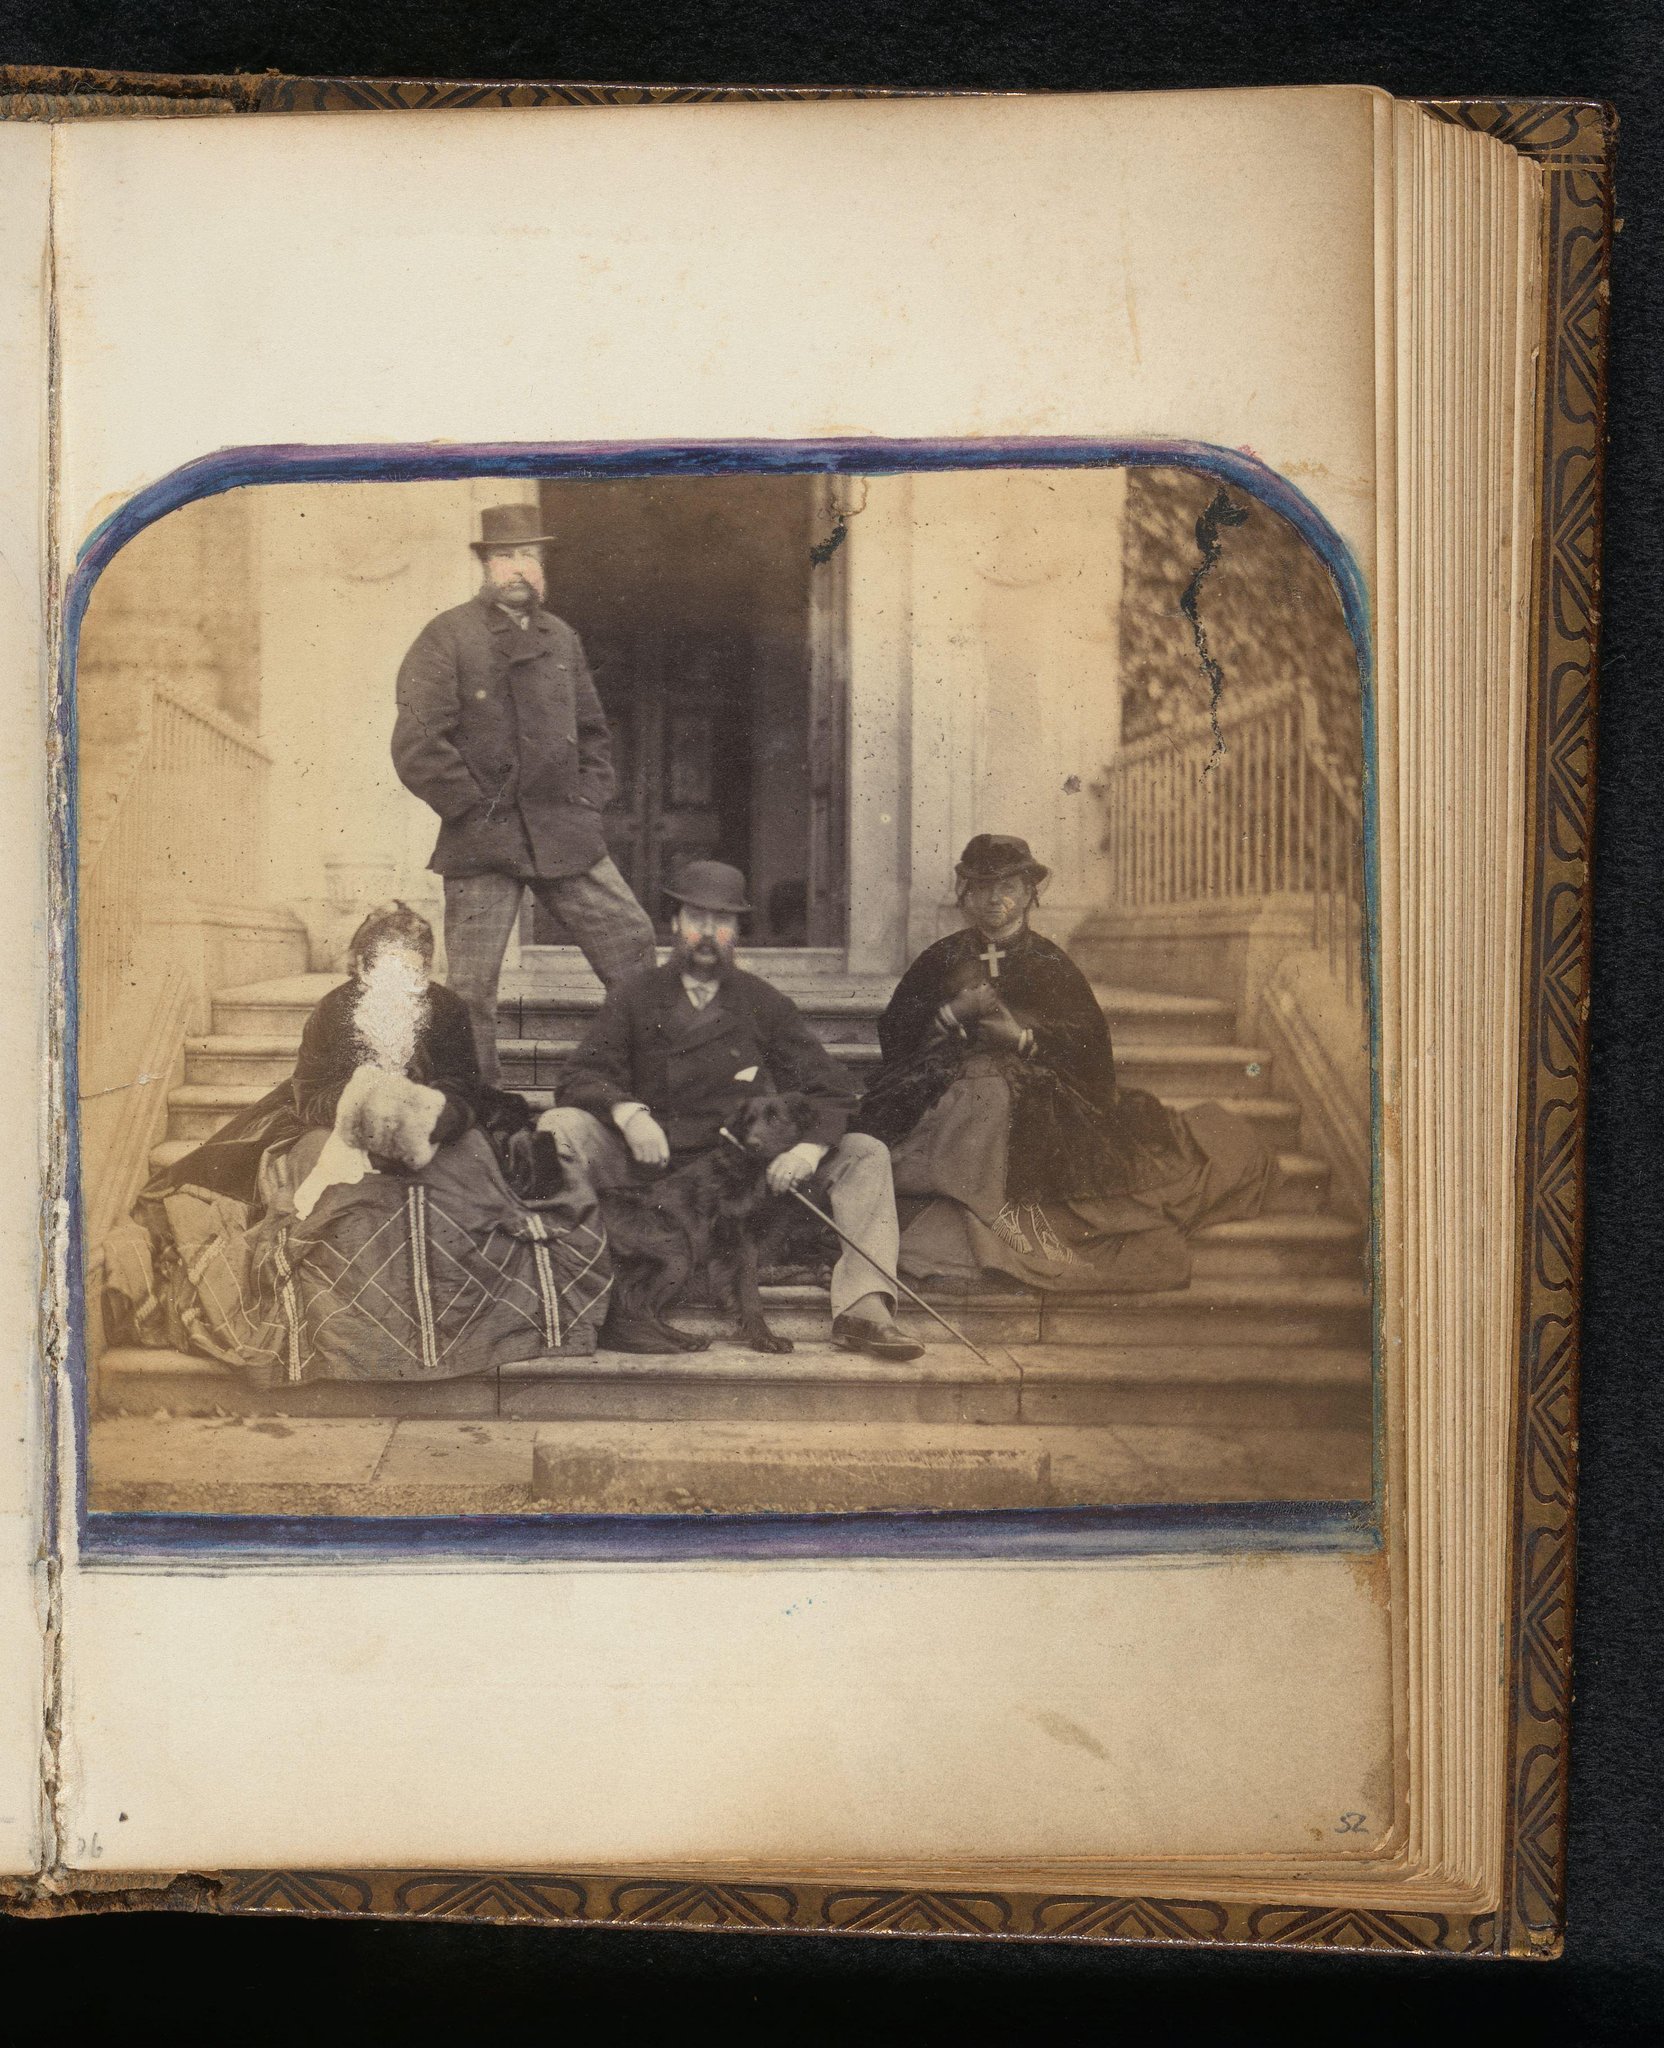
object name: photograph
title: Groepsportret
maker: Anonymous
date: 1865-1867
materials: cardboard, photographic support, watercolor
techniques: albumen print, aquarelle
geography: england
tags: historical persons not known by name - bb - woman, front steps, historical persons not known by name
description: Groepsportret van twee vrouwen en twee mannen zittend buiten op een trap. Foto op albumblad in album met 68 foto's merendeels met geaquarelleerde randversieringen. Het zijn voornamelijk portretten op carte-de-visite formaat.